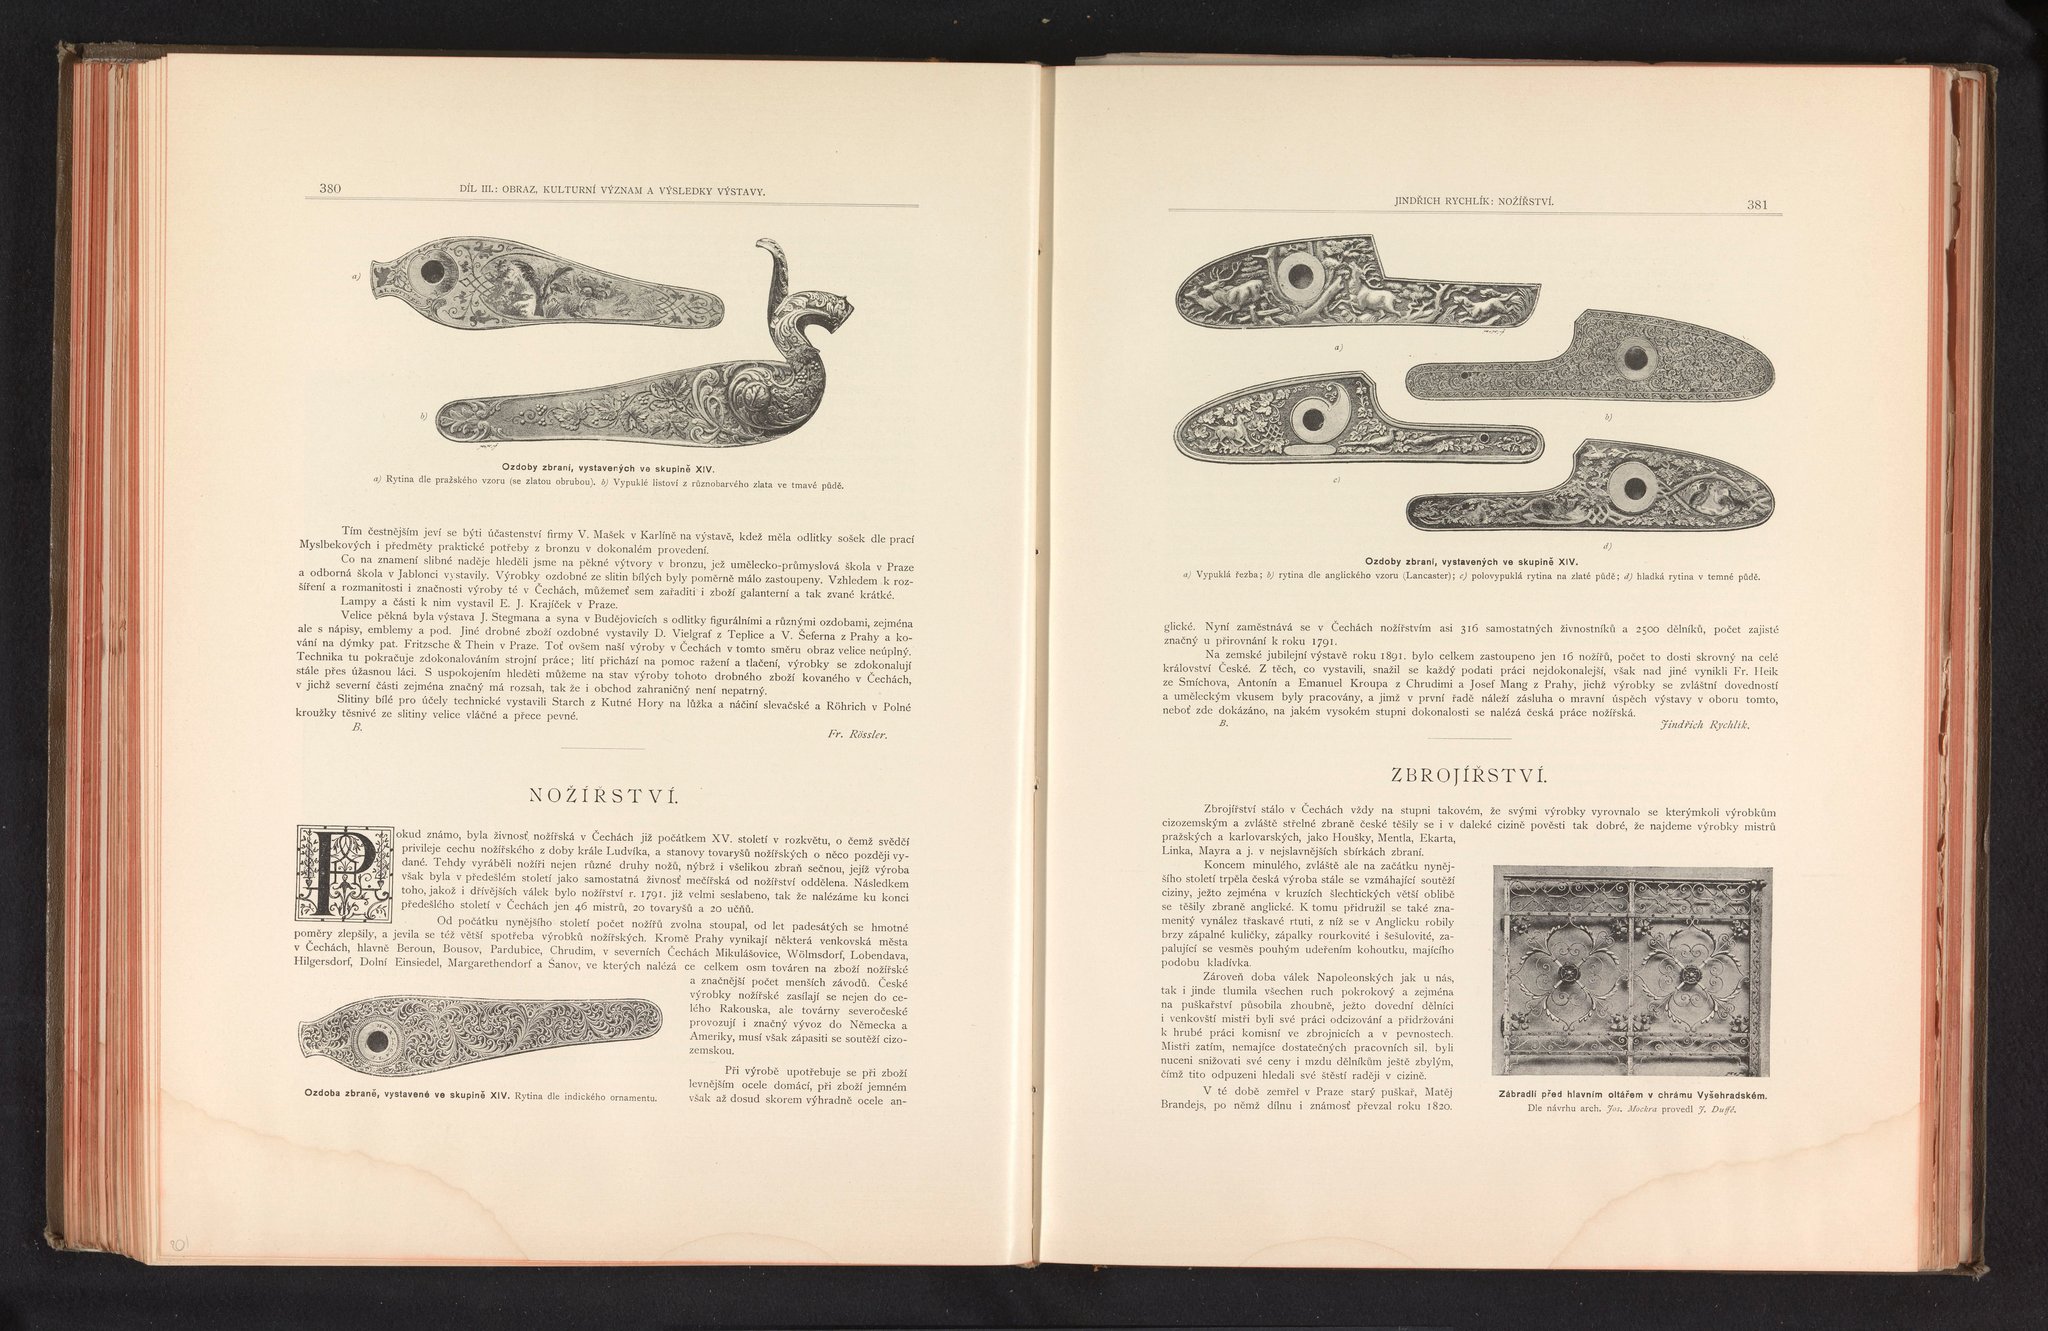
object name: photomechanical print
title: Ozdoby zbrani, vystavených ve skupine XIV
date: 1890-1895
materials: paper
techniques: autotype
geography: prague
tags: ornaments ~ art, weapons, ornament derived from plant forms